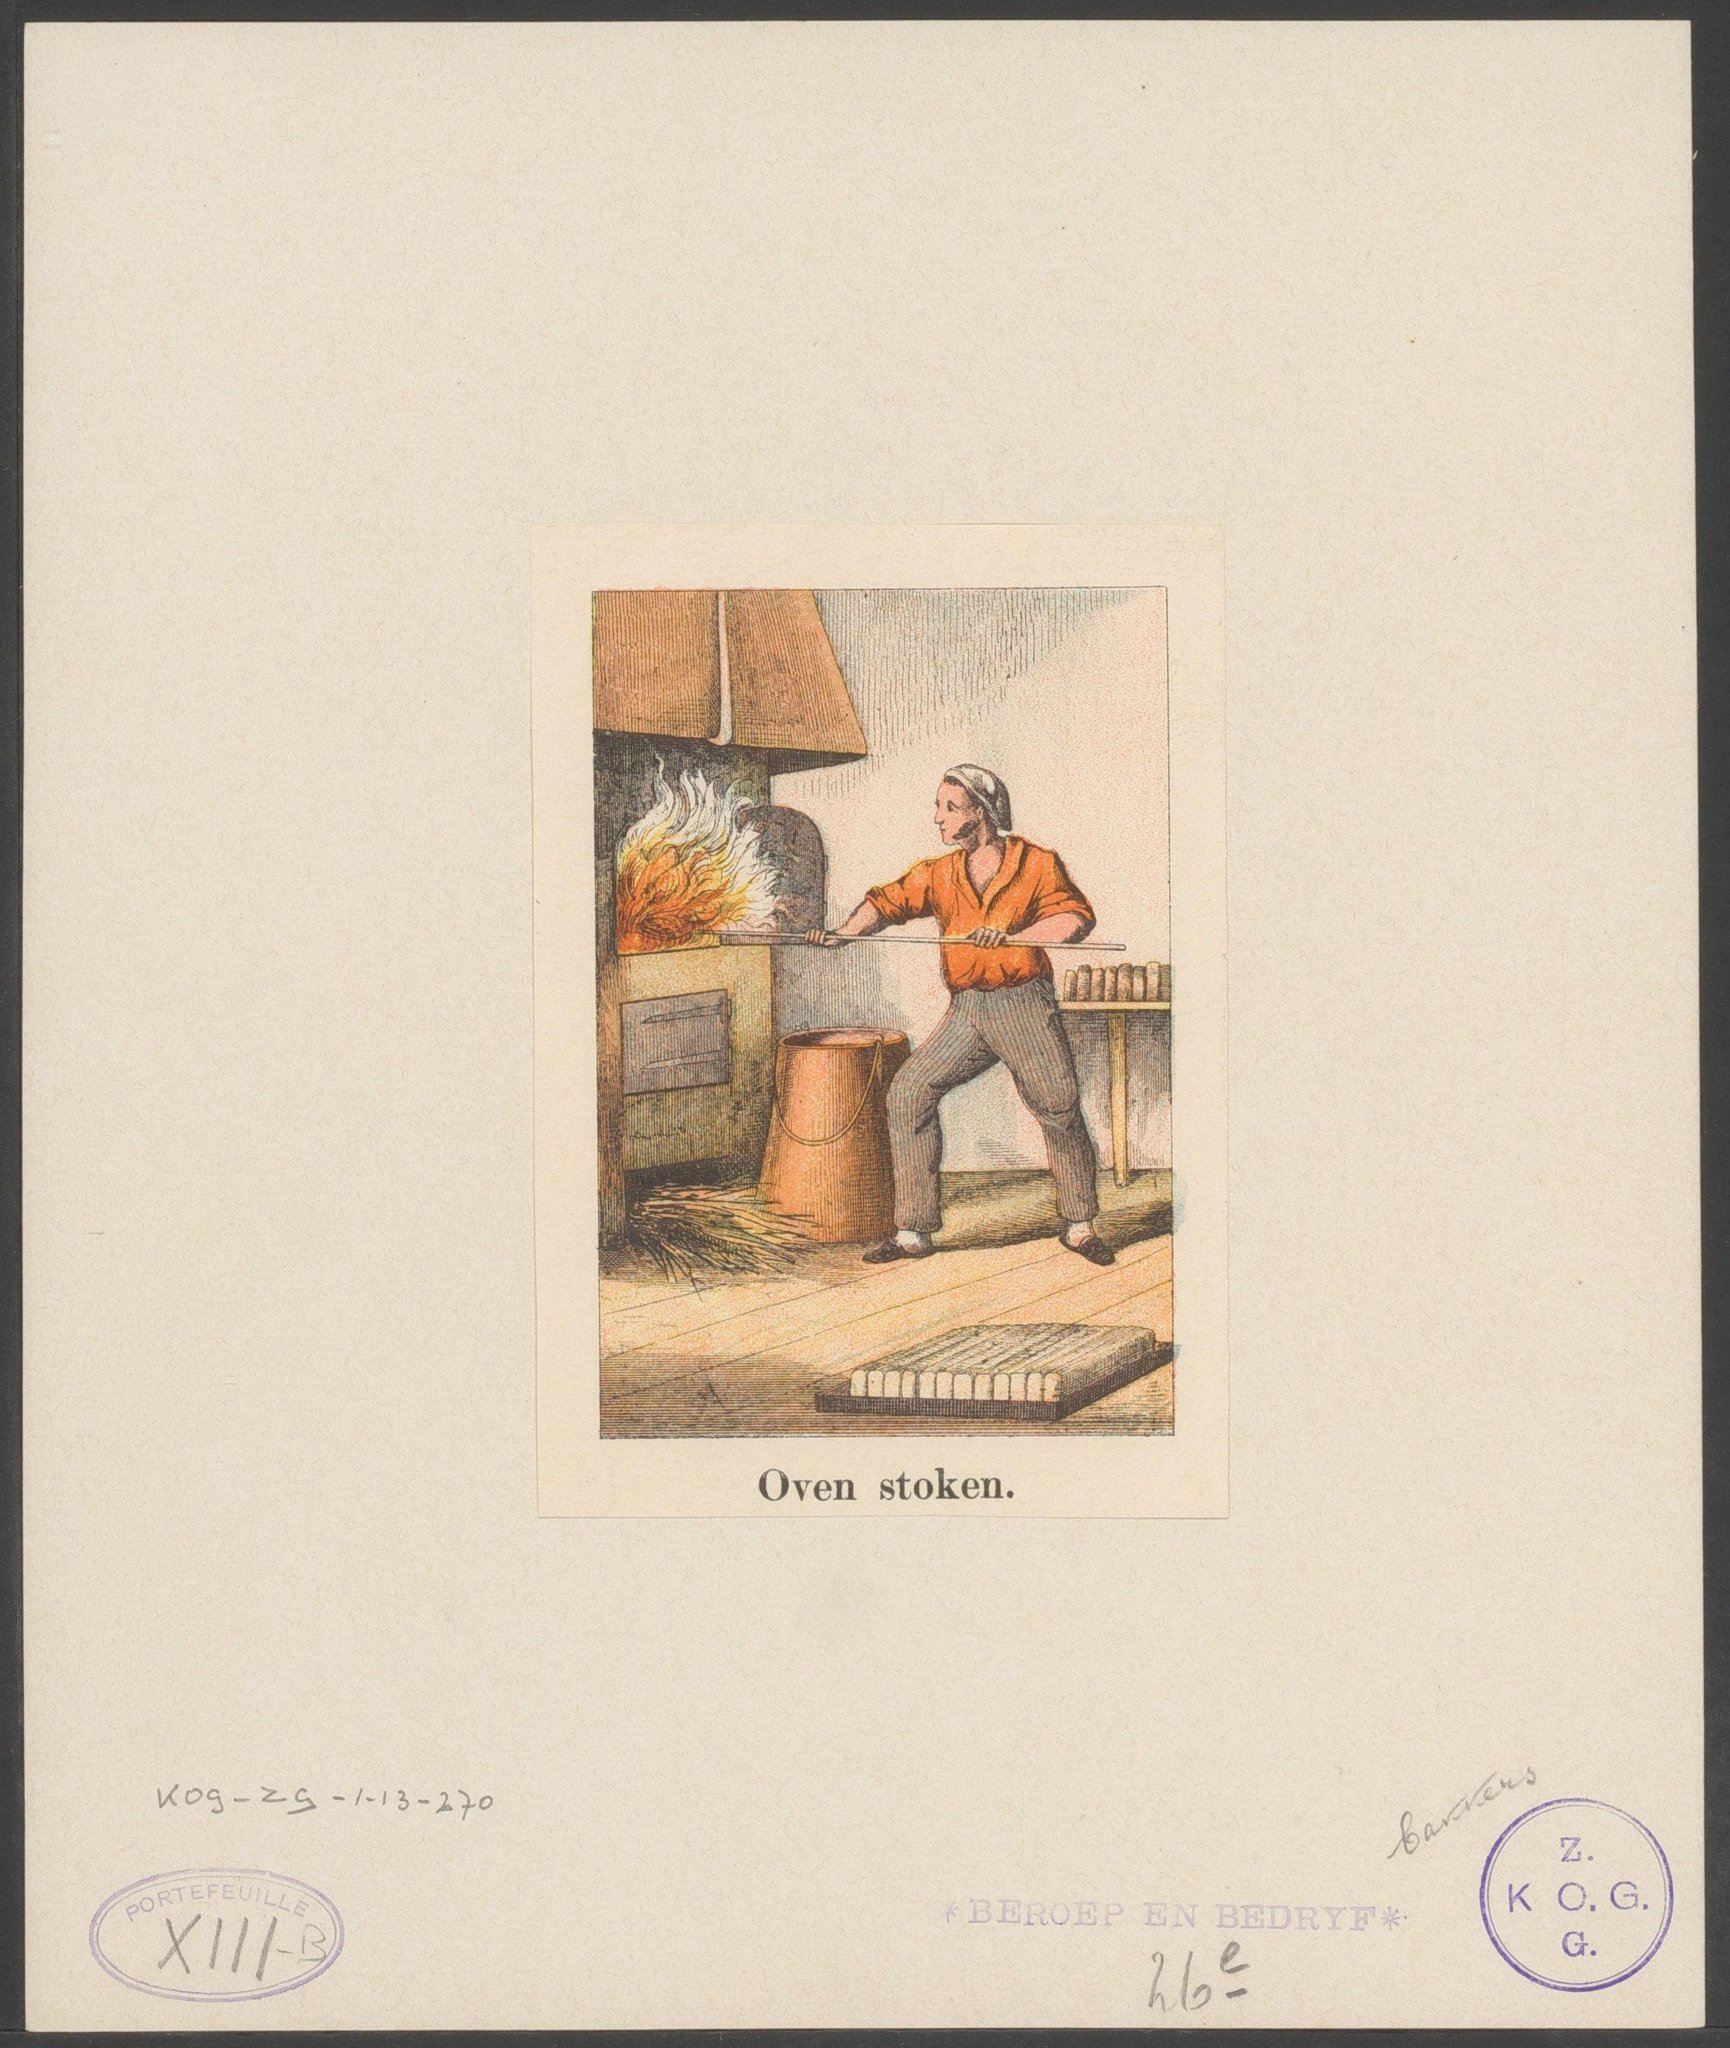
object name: popular print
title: Oven stoken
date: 1865-1872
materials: paper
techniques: lithograph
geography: amsterdam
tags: baker (+ labourers ~ crafts, industries, agriculture), baker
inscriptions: stamp, stamp, collector's mark: Lugt 1641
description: Onderwerpsrubrieken binnen de Atlas Zeden en Gewoonten: Handel, Nijverheid en Verkeer, Beroep en bedrijf, Mannelijk, Eet- en drinkwaren.